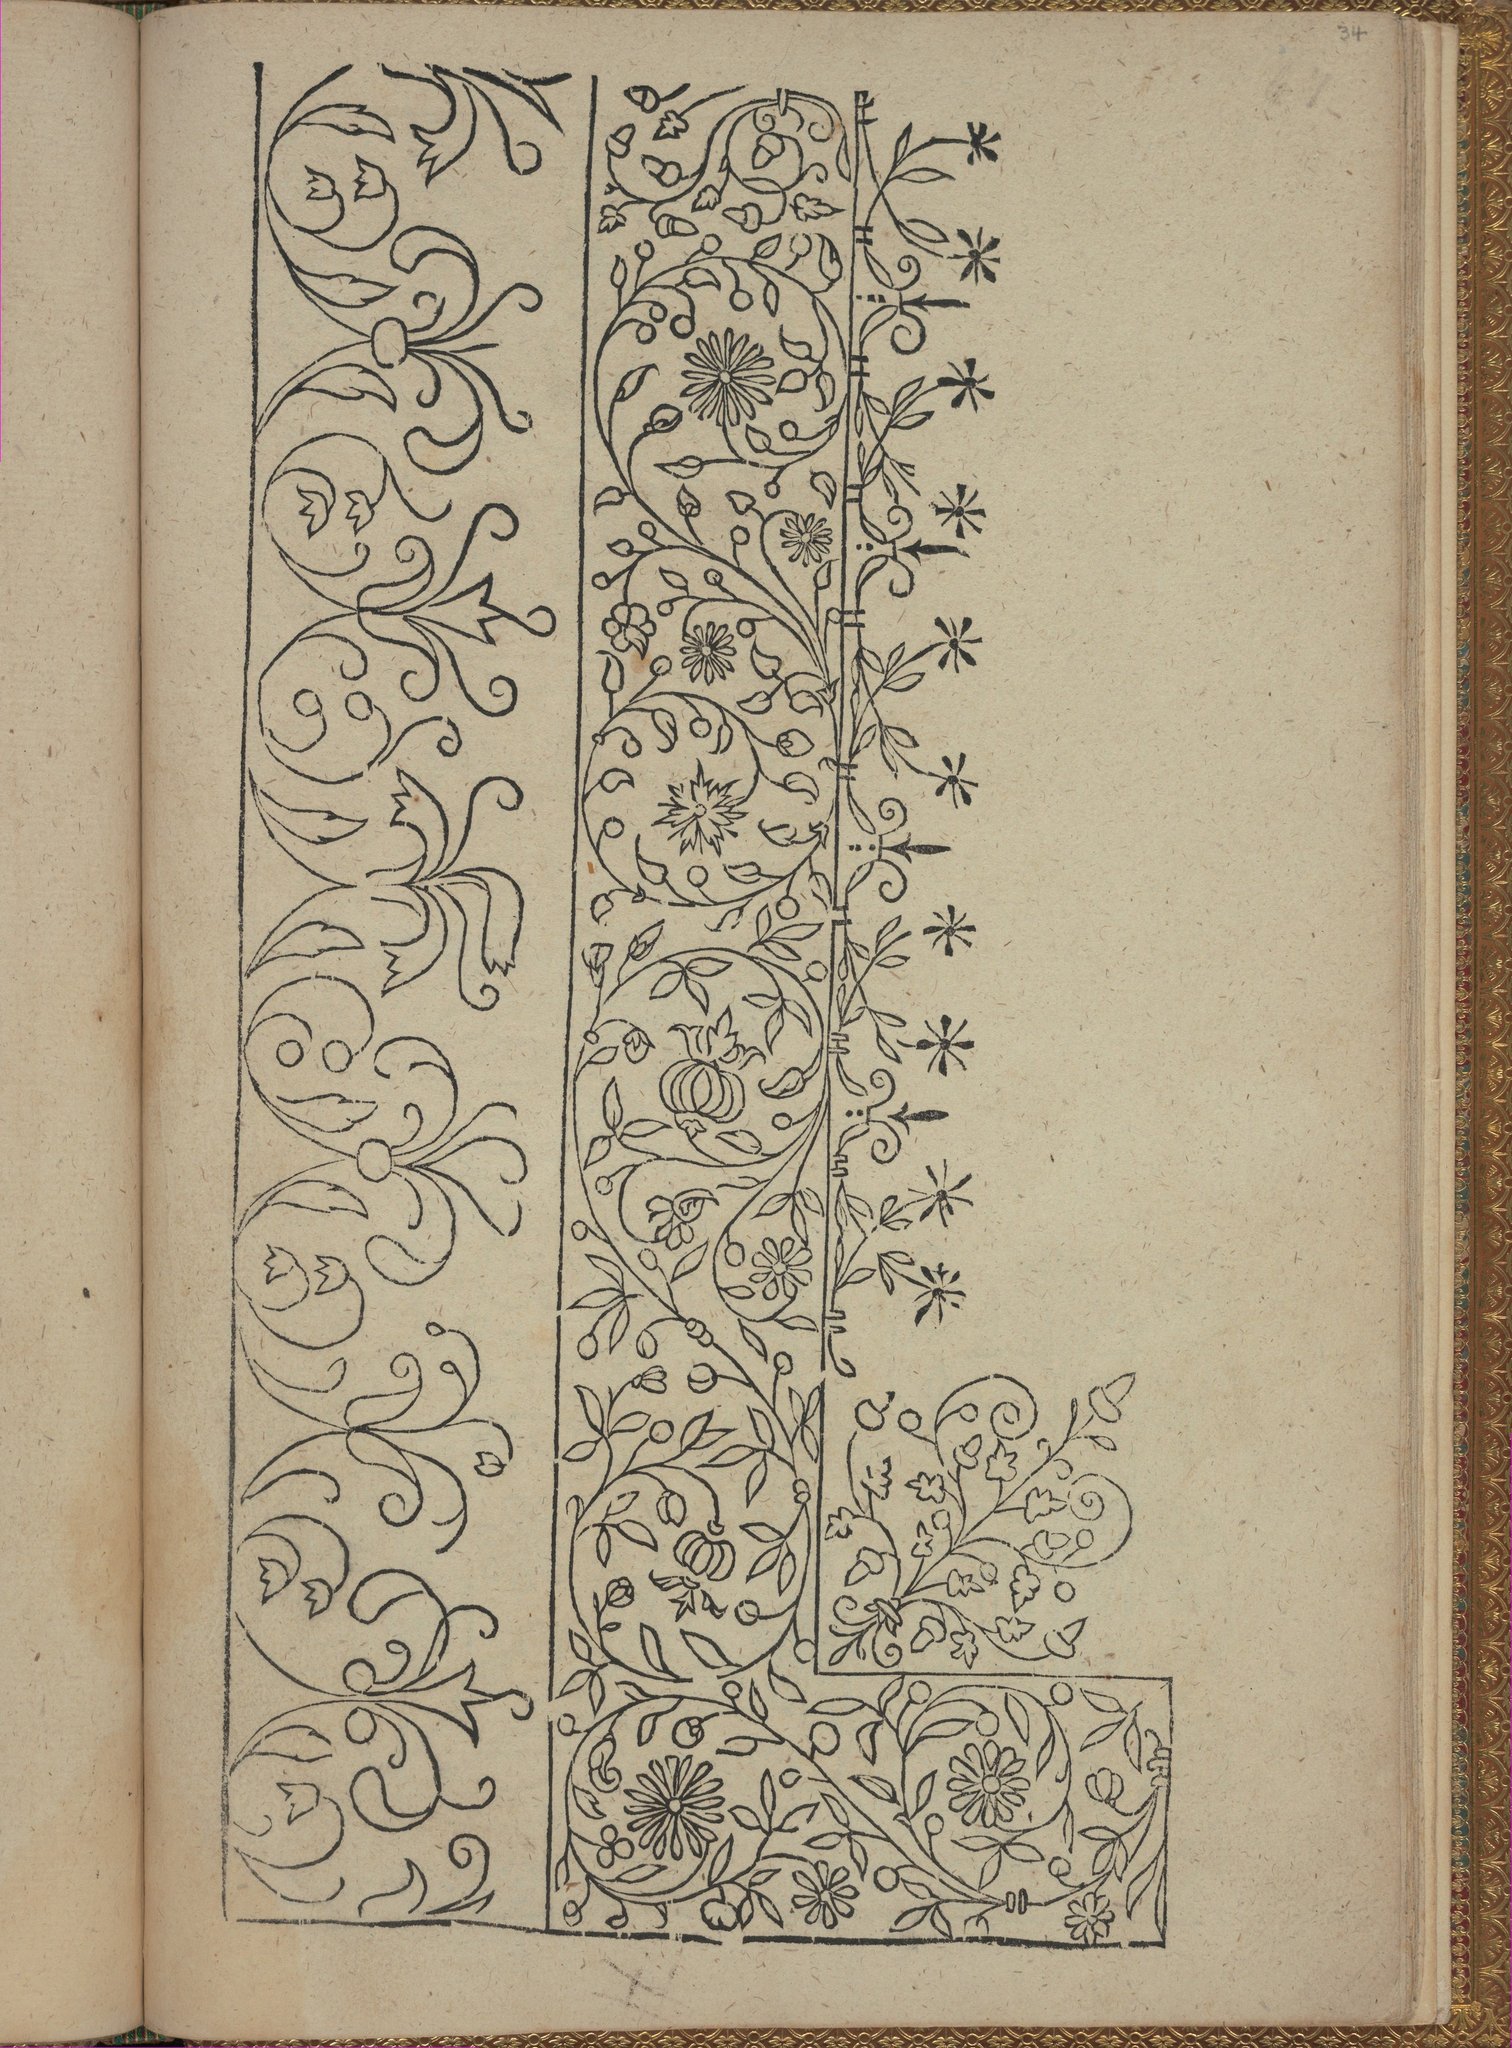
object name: book print ornament architecture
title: New Modelbüch (Page 34r)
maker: andreas bretschneider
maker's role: designer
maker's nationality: german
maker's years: 1573-1645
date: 1615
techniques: woodcut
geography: germany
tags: ornament